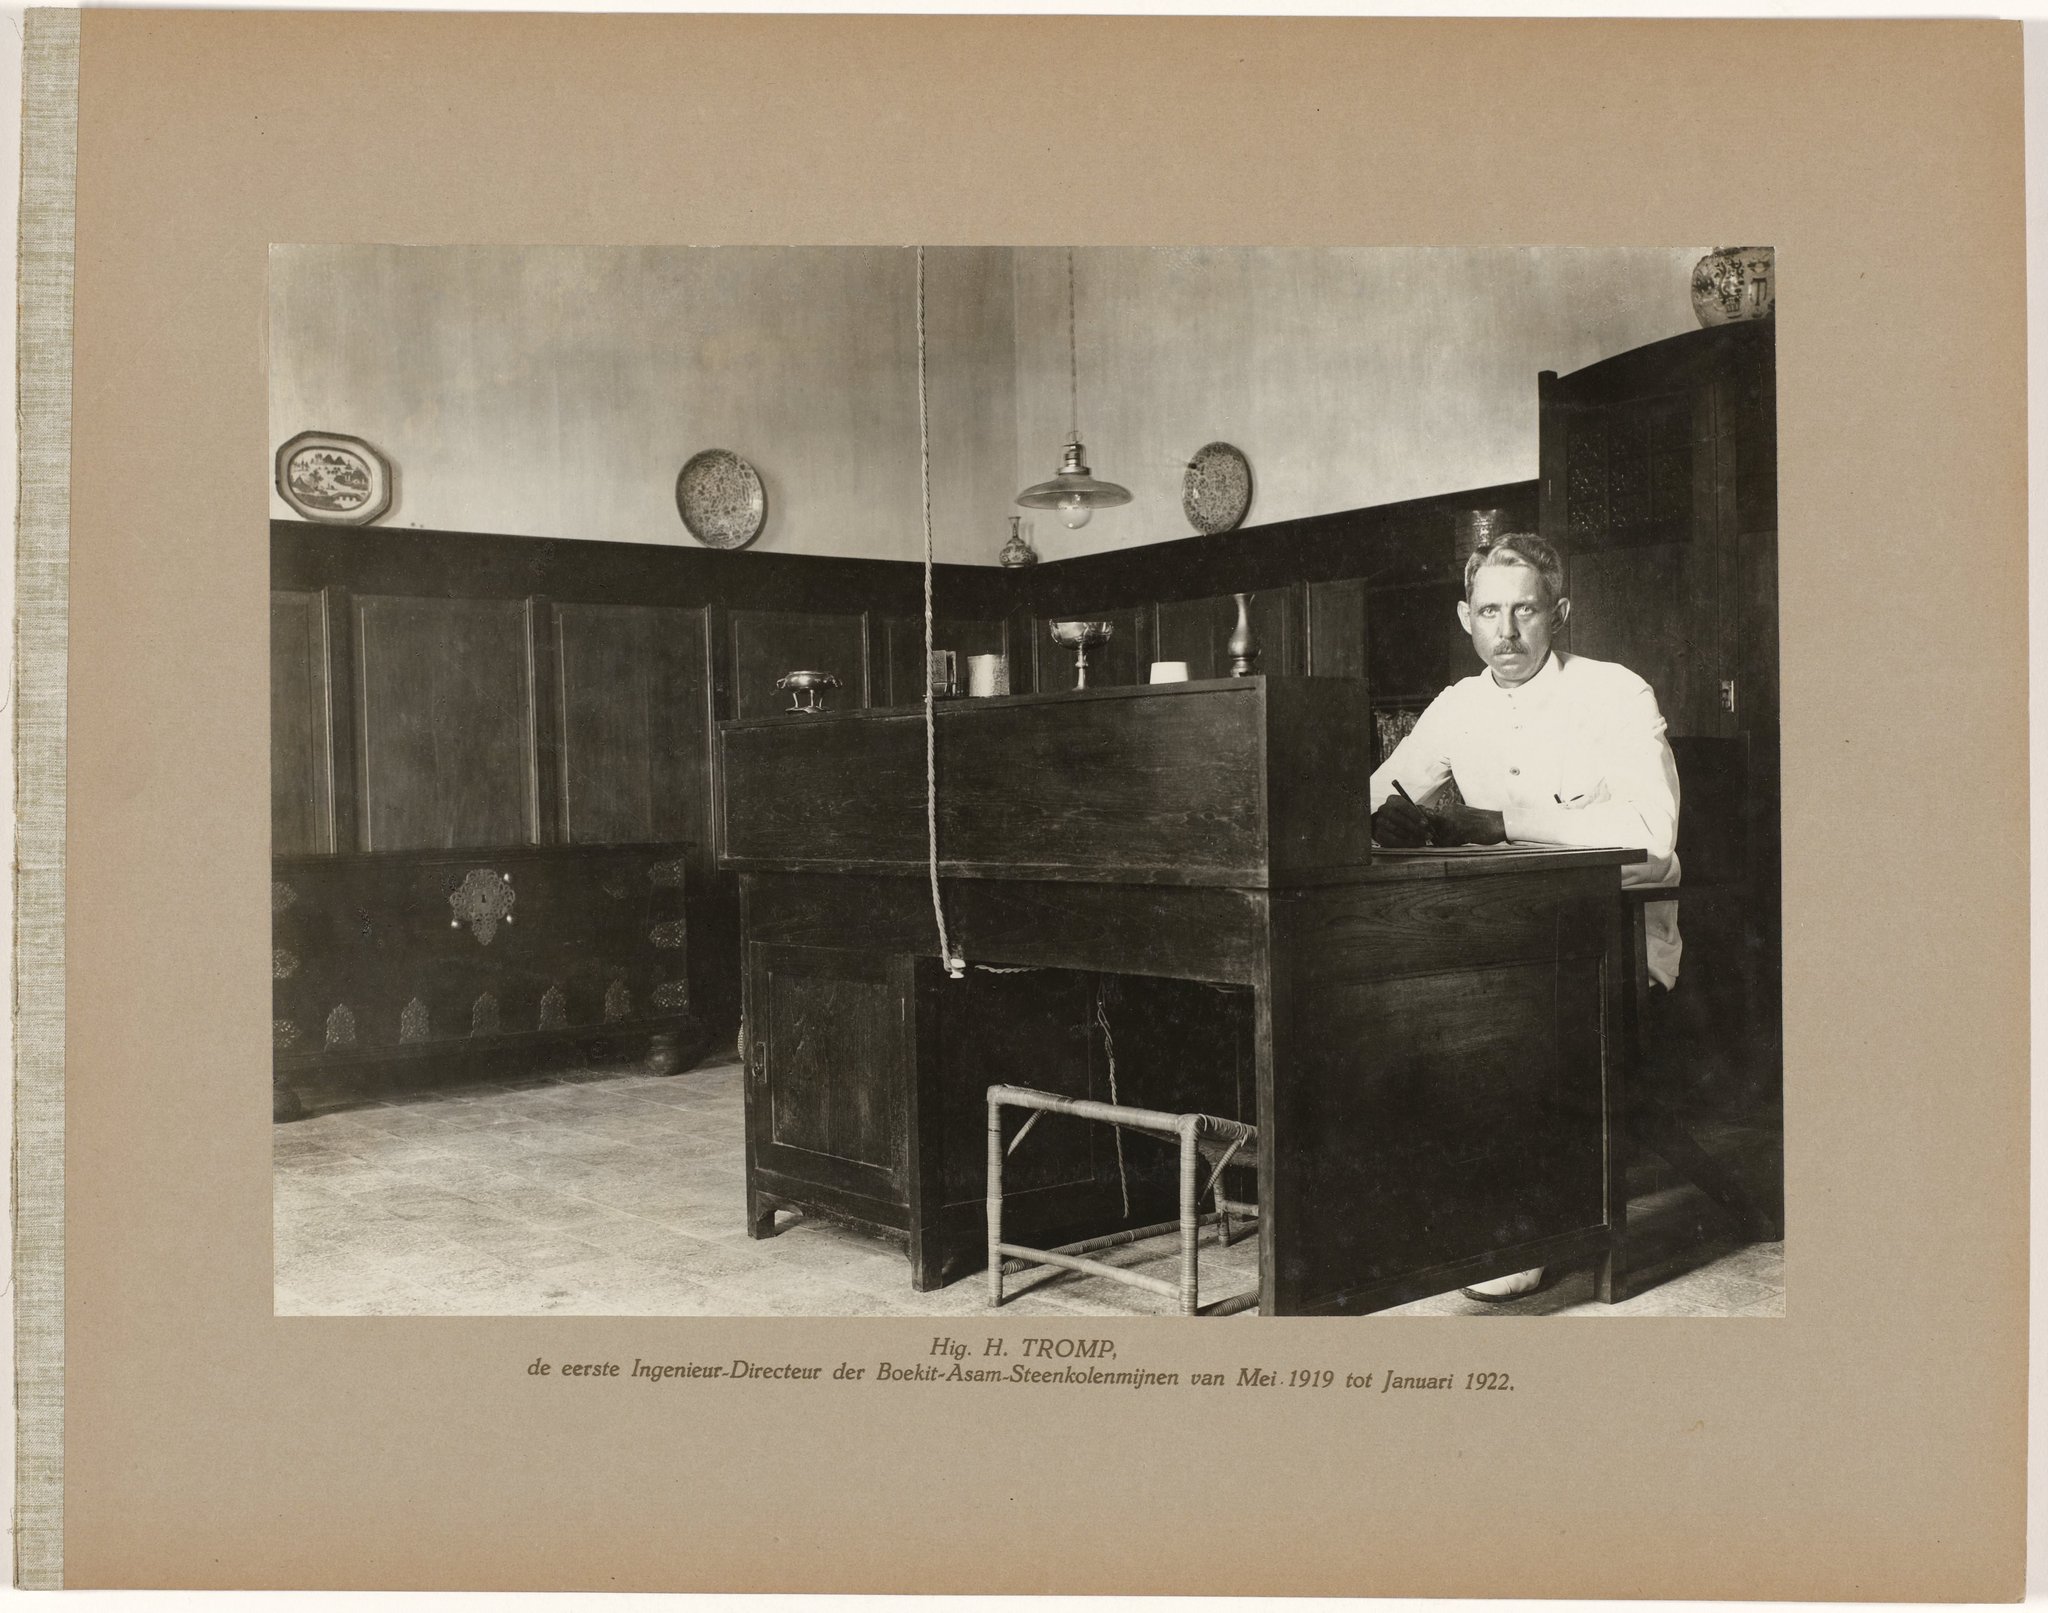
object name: photograph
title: Hig. H. Tromp, de eerste Ingenieur-Directeur der Boekit-Asam-Steenkolenmijnen van Mei 1919 tot Januari 1922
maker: Anonymous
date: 1921-1922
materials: photographic support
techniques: gelatin silver print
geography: bukit asam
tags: colonial system, anthracite, hard coal, historical persons, opencast mine; strip mining (+ coal), sumatra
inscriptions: inscription: ‘Hig. H. Tromp, de eerste Ingenieur-Directeur der Boekit-Asam-Steenkolenmijnen van Mei 1919 tot Januari 1922.’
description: Directeur H. Tromp zittend achter zijn bureau in het kantoor van de steenkolenmijn. Onderdeel van het losbladige fotoalbum aangeboden door het personeel van de Boekit-Asam Steenkolenmijnen op Sumatra aan de scheidende Ingenieur-Directeur H. Tromp op 7 januari 1922.